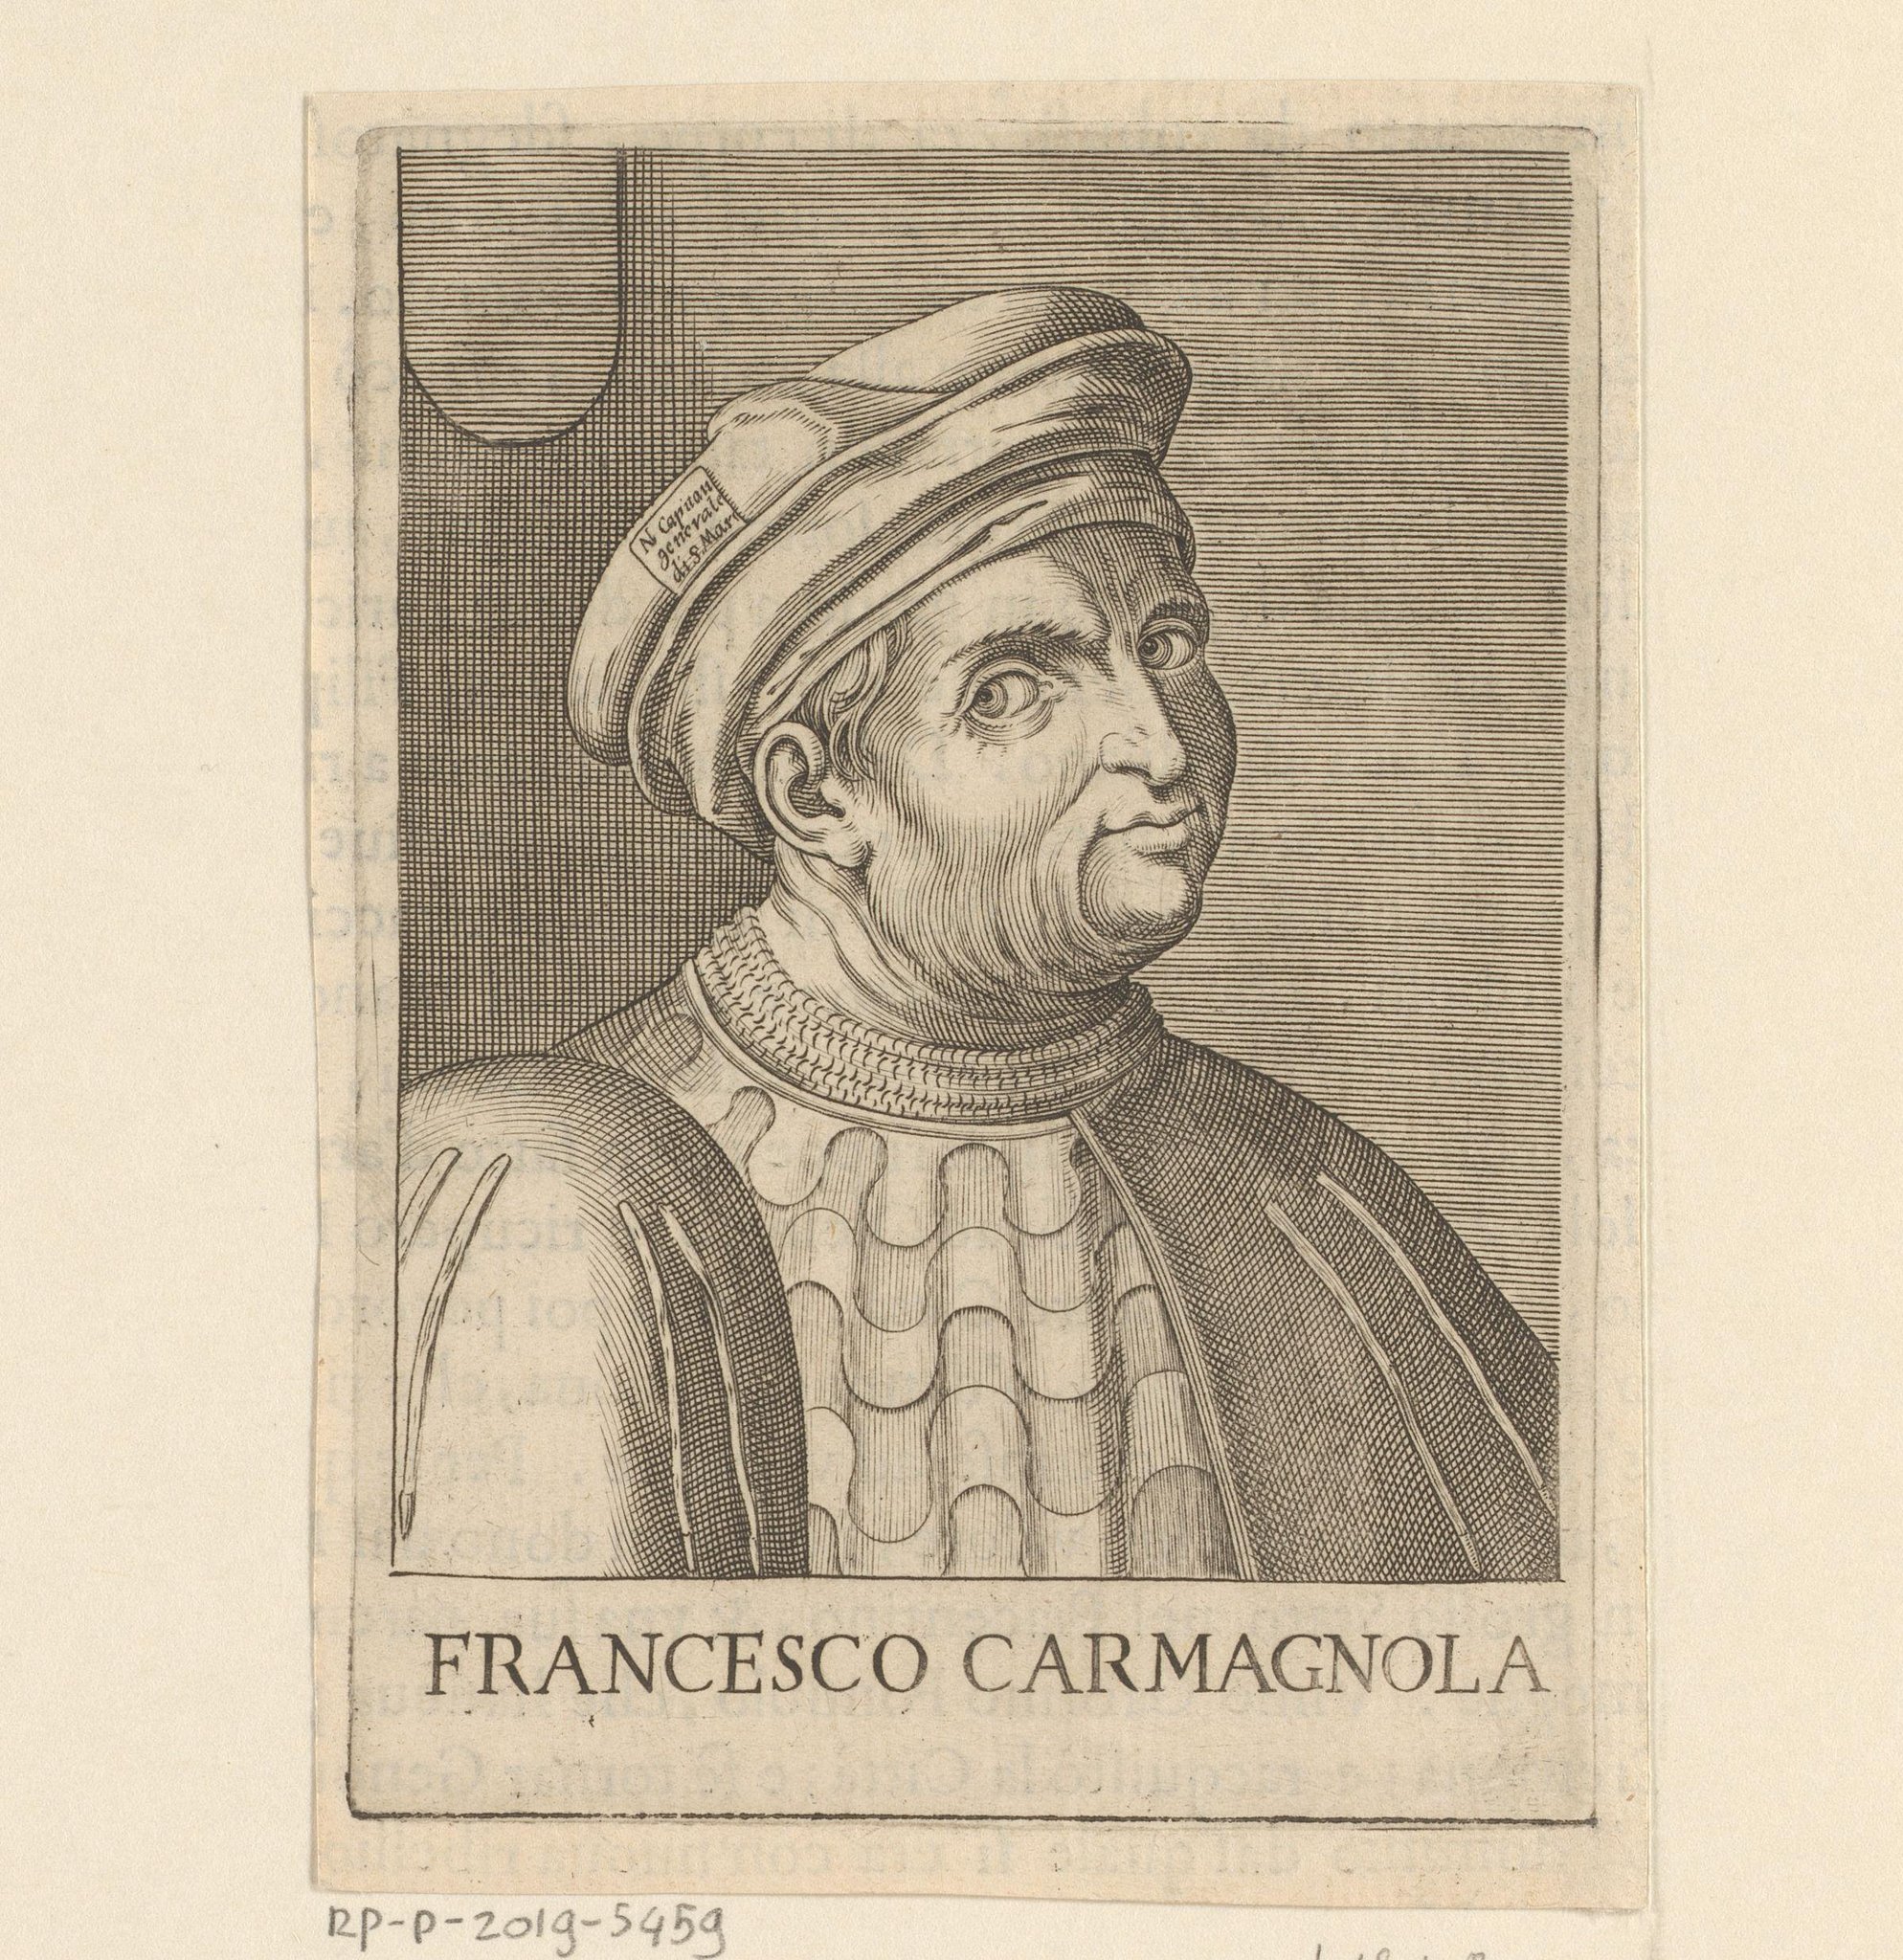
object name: print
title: Francesco Carmagnola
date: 1646-1647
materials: paper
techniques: engraving, letterpress printing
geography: rome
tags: venice, commander-in-chief, general, marshal, historical persons, armorial bearing, heraldry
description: Prent uit: Ritratti et elogii di capitani Illustri. Che ne'secoli moderni hanno gloriosamente guerreggiato. Rome: Filippo de'Rossi en Vitale Mascardi, 1646, p. 83. Prent ook gebruikt in dezelfde editie van 1647. Eerdere staten van prent in ieder geval gebruikt in: Ritratti et elogii di capitani Illustri. Rome: Pompilio Totti en Andrea Fei, 1635. En in: Ritratti di cento capitani illustri con li lor Fatti in guerra (…), Rome: Domenico Gigliotti, 1596.